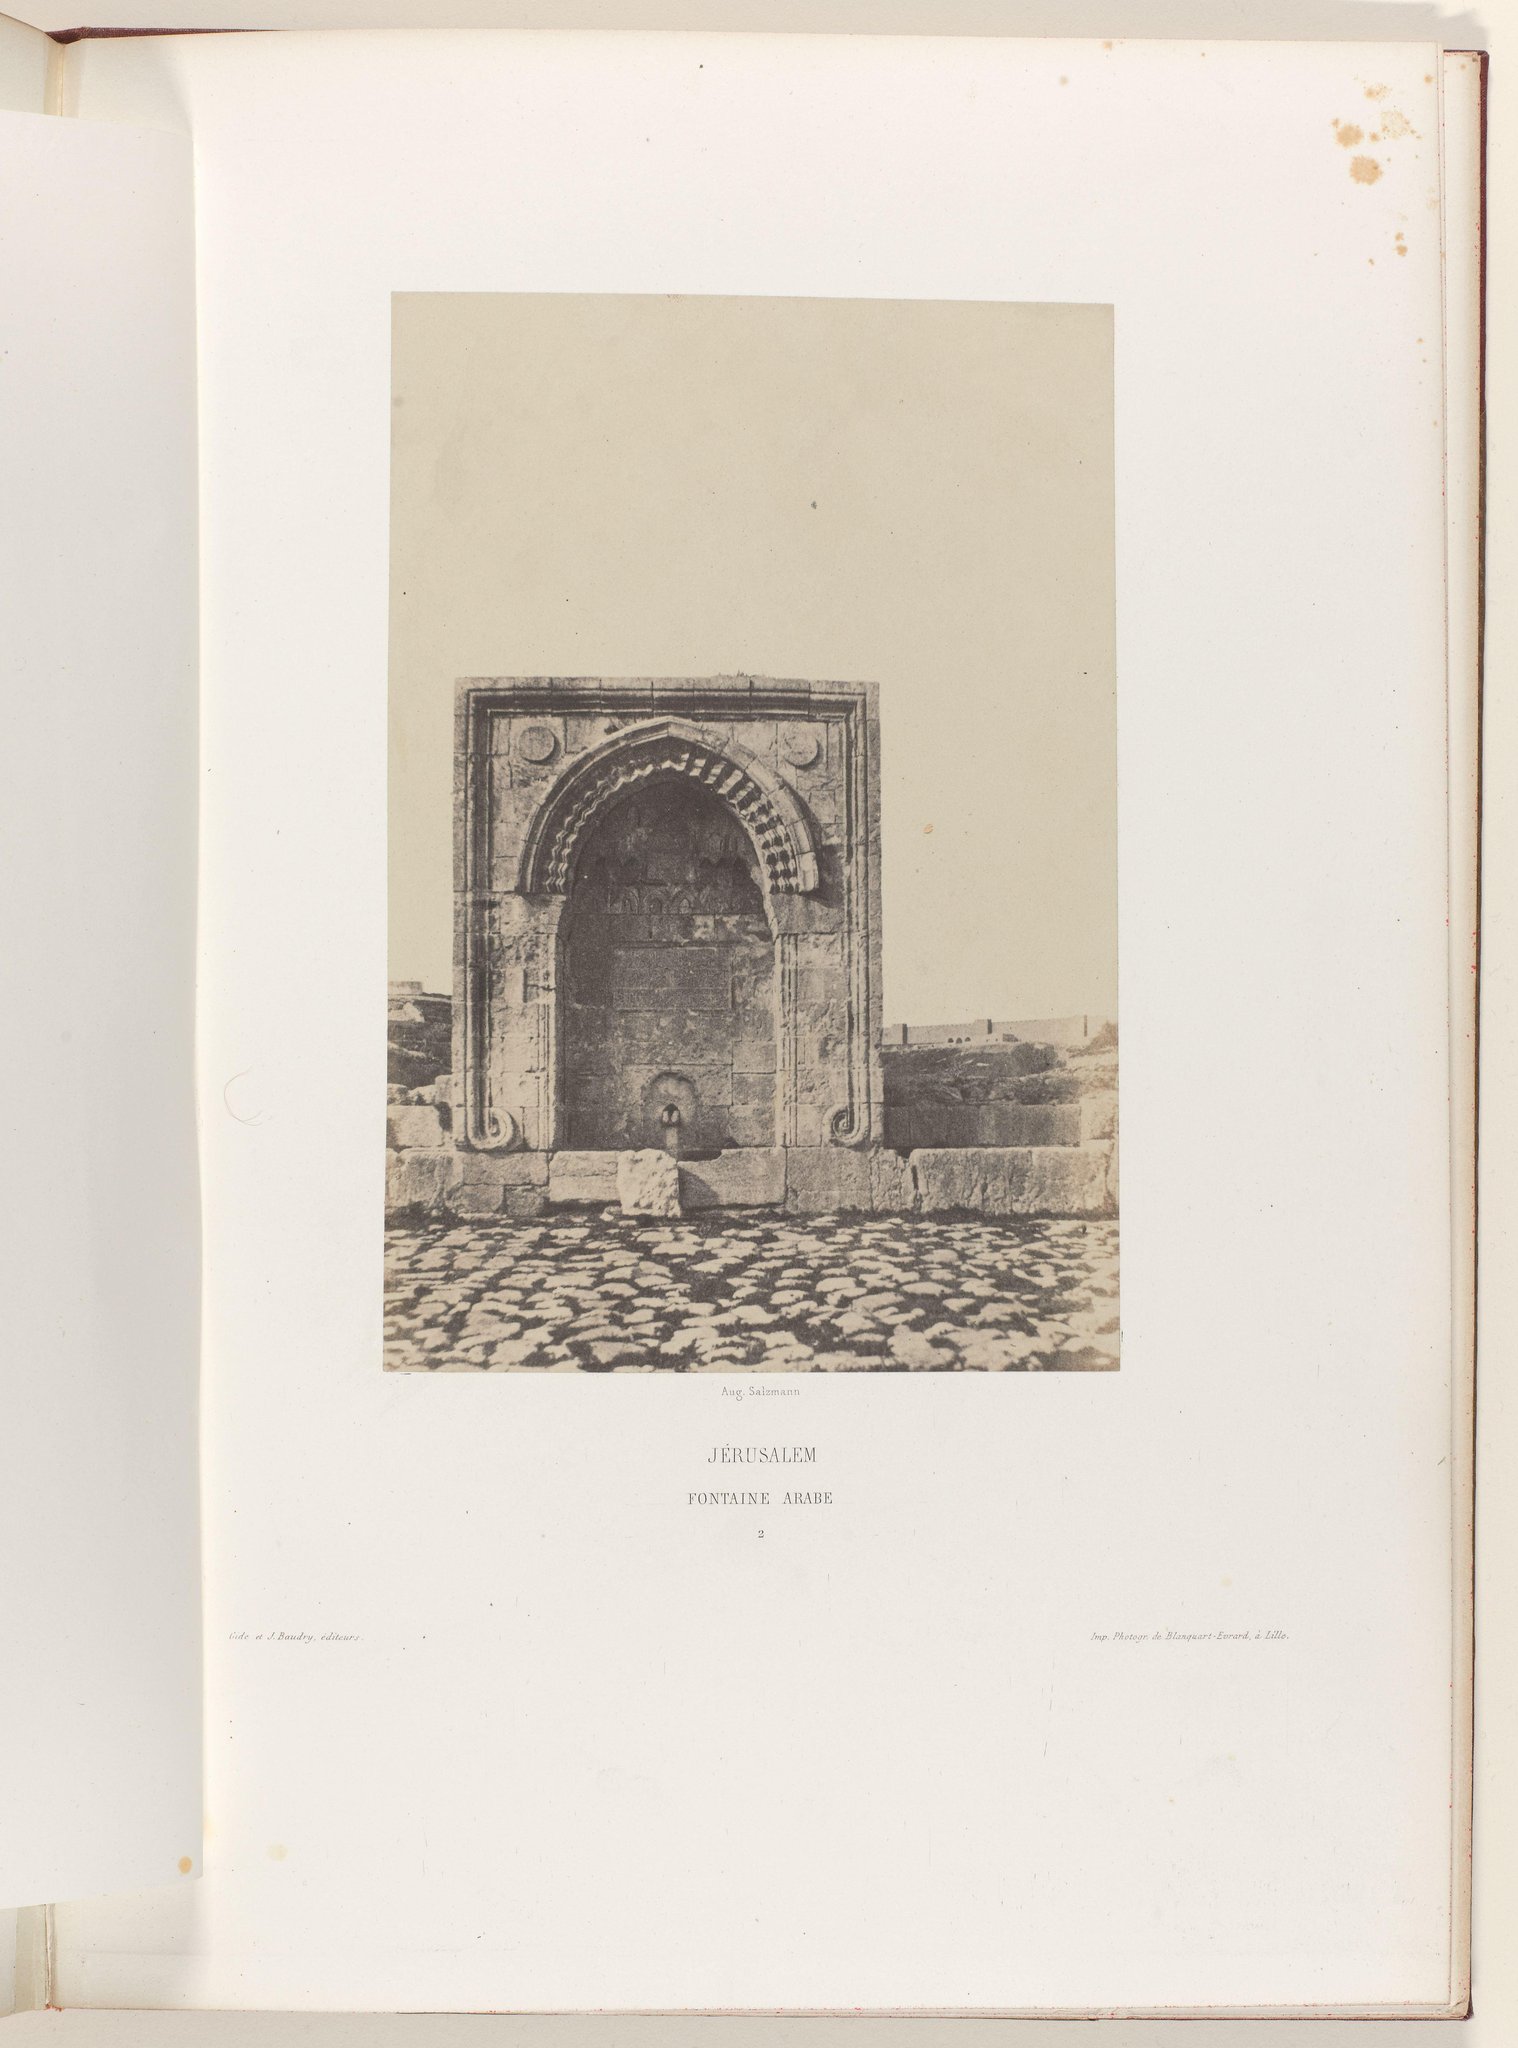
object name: photograph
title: Arabische fontein te Jeruzalem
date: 1854-1856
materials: cardboard, paper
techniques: salted paper print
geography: paris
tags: ornamental fountain